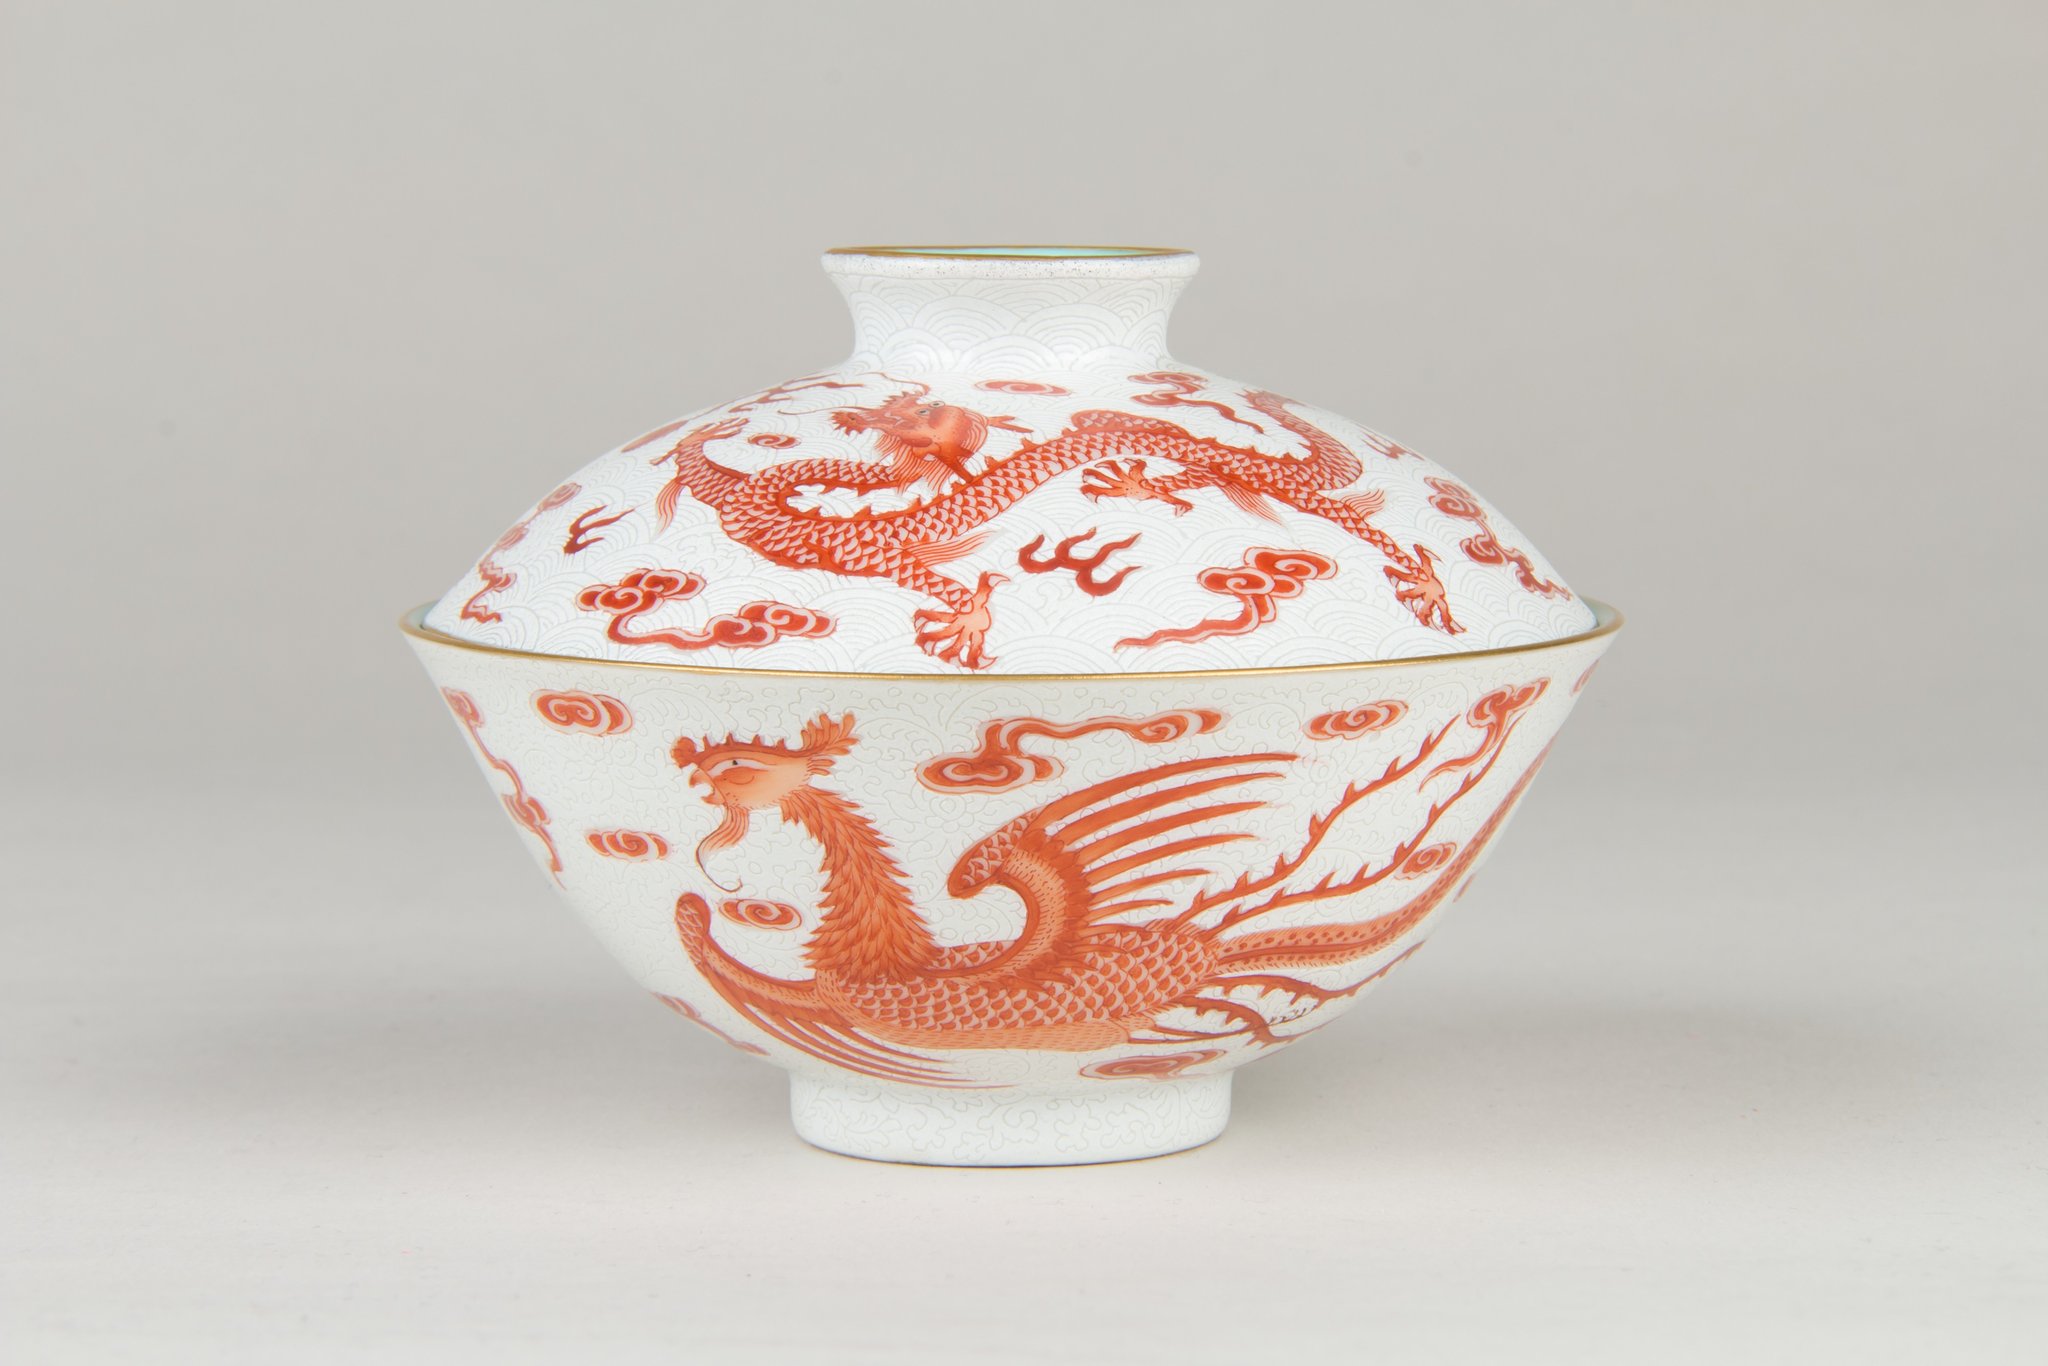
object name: covered bowl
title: Covered Bowl (one of a pair)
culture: chinese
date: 1701-1800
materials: porcelain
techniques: carving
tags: dragons